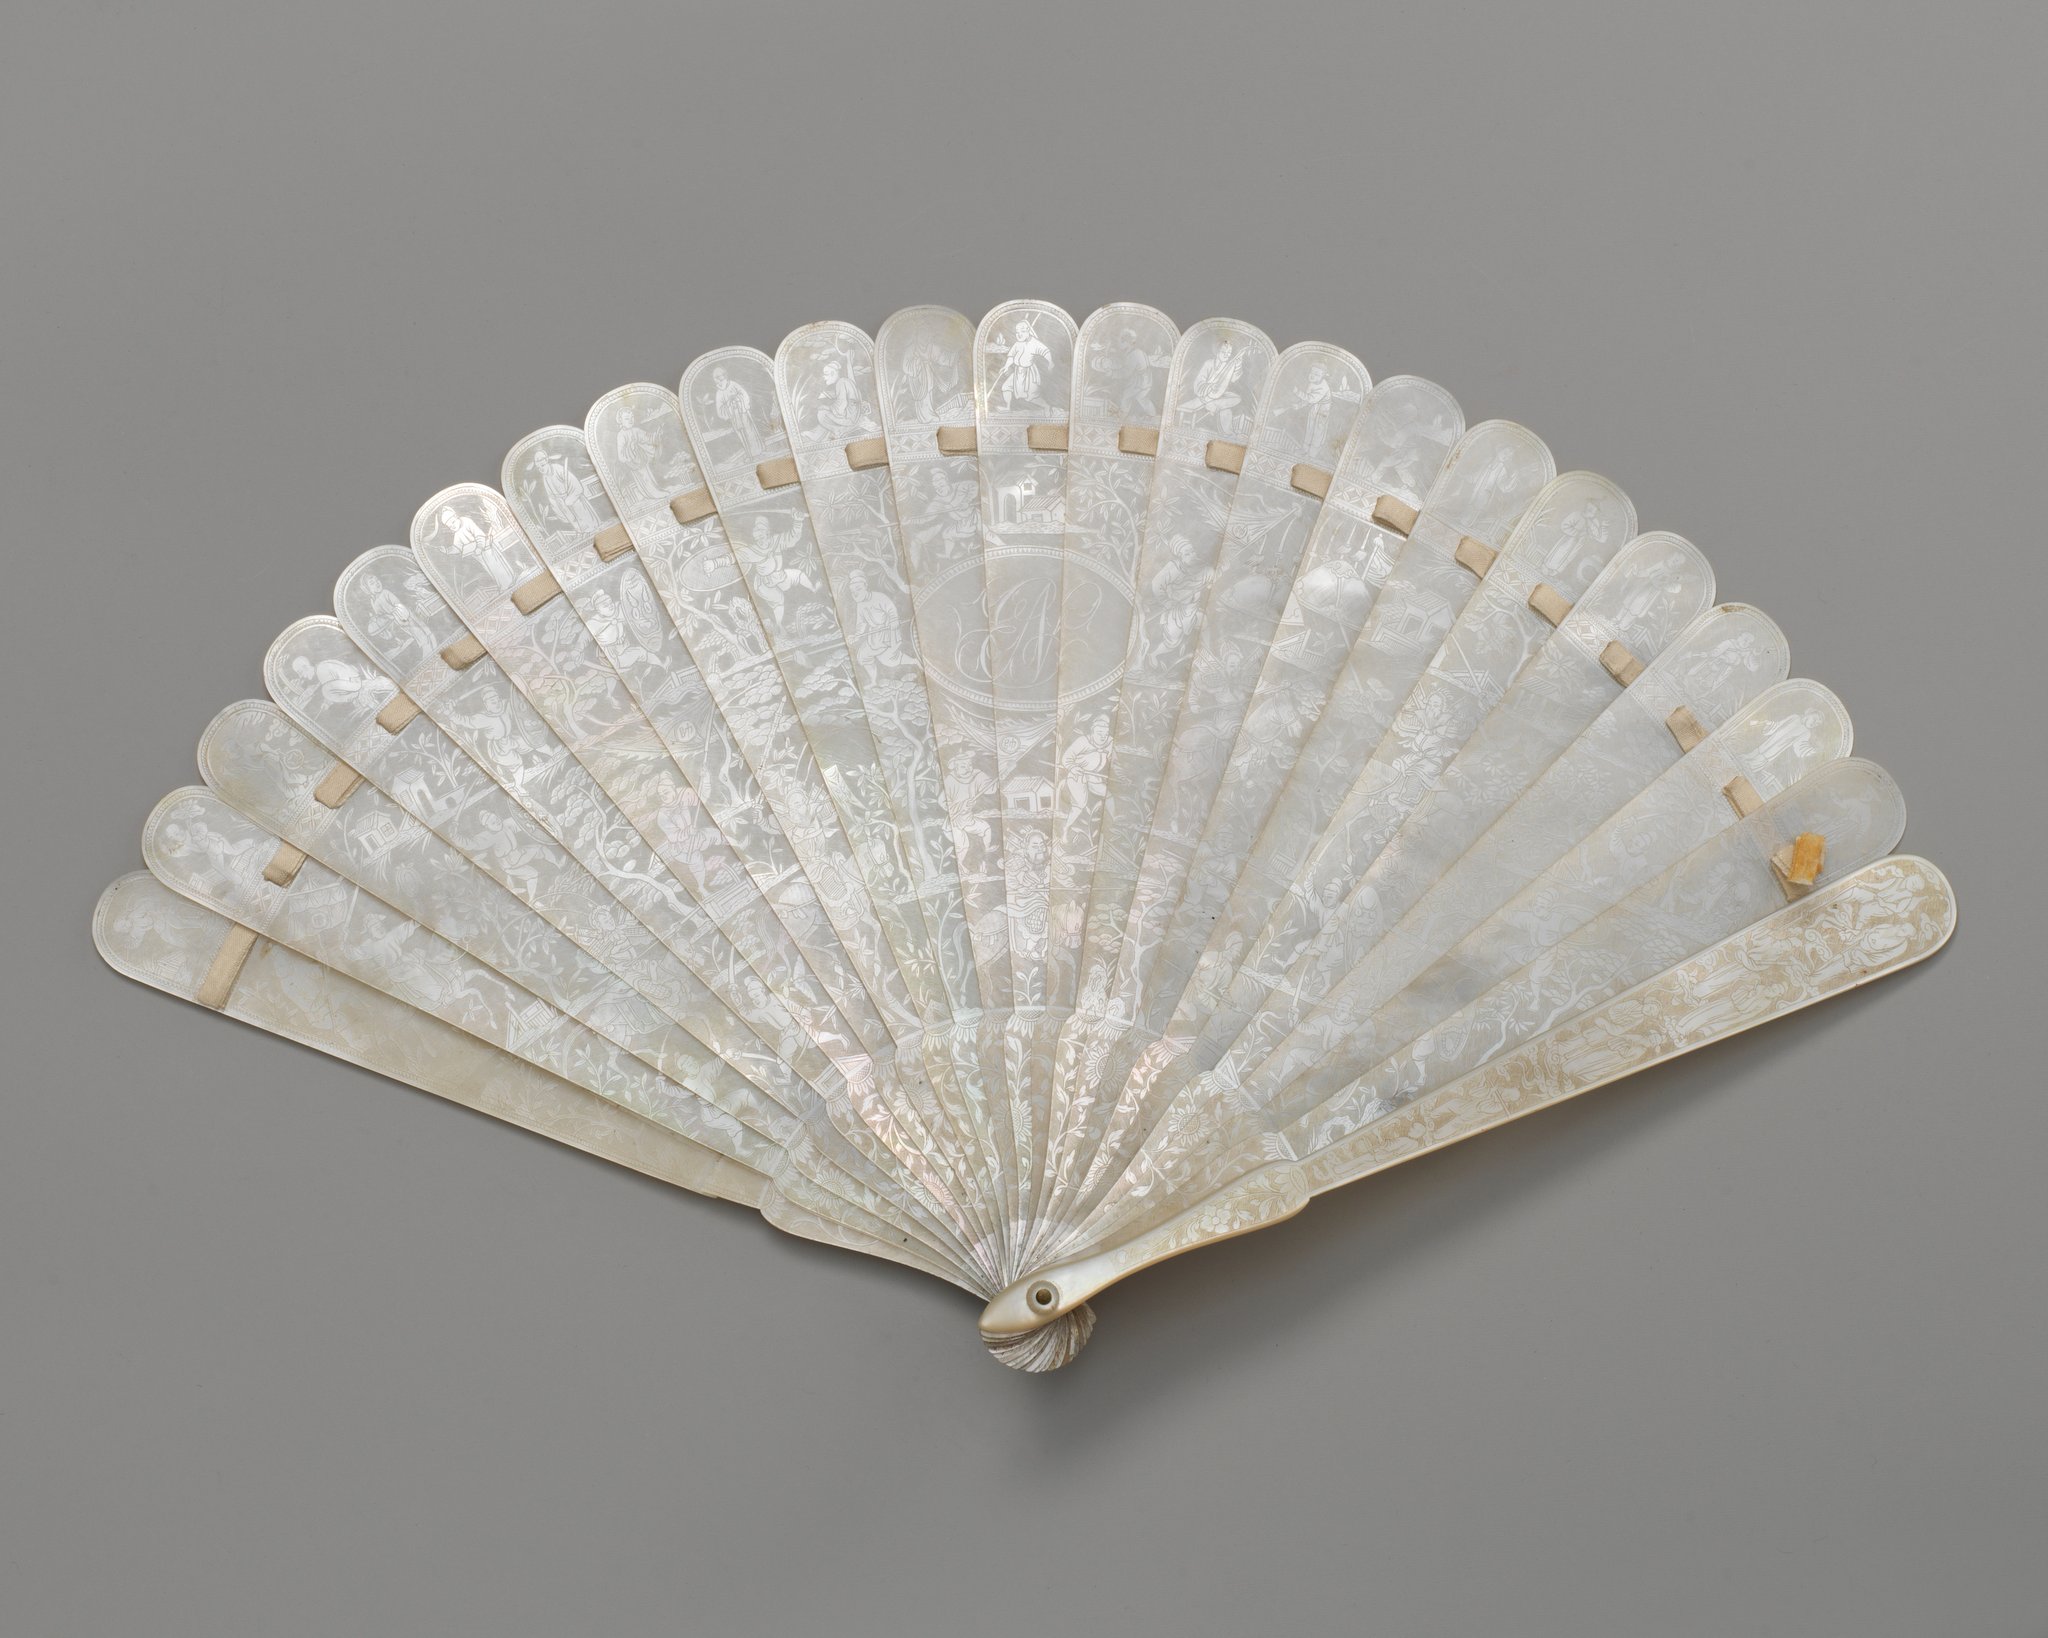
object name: fan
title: Brisé Fan, with representations of warriors in a Chinese landscape, and EN monogram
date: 1801-1833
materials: mother of pearl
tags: men,horses